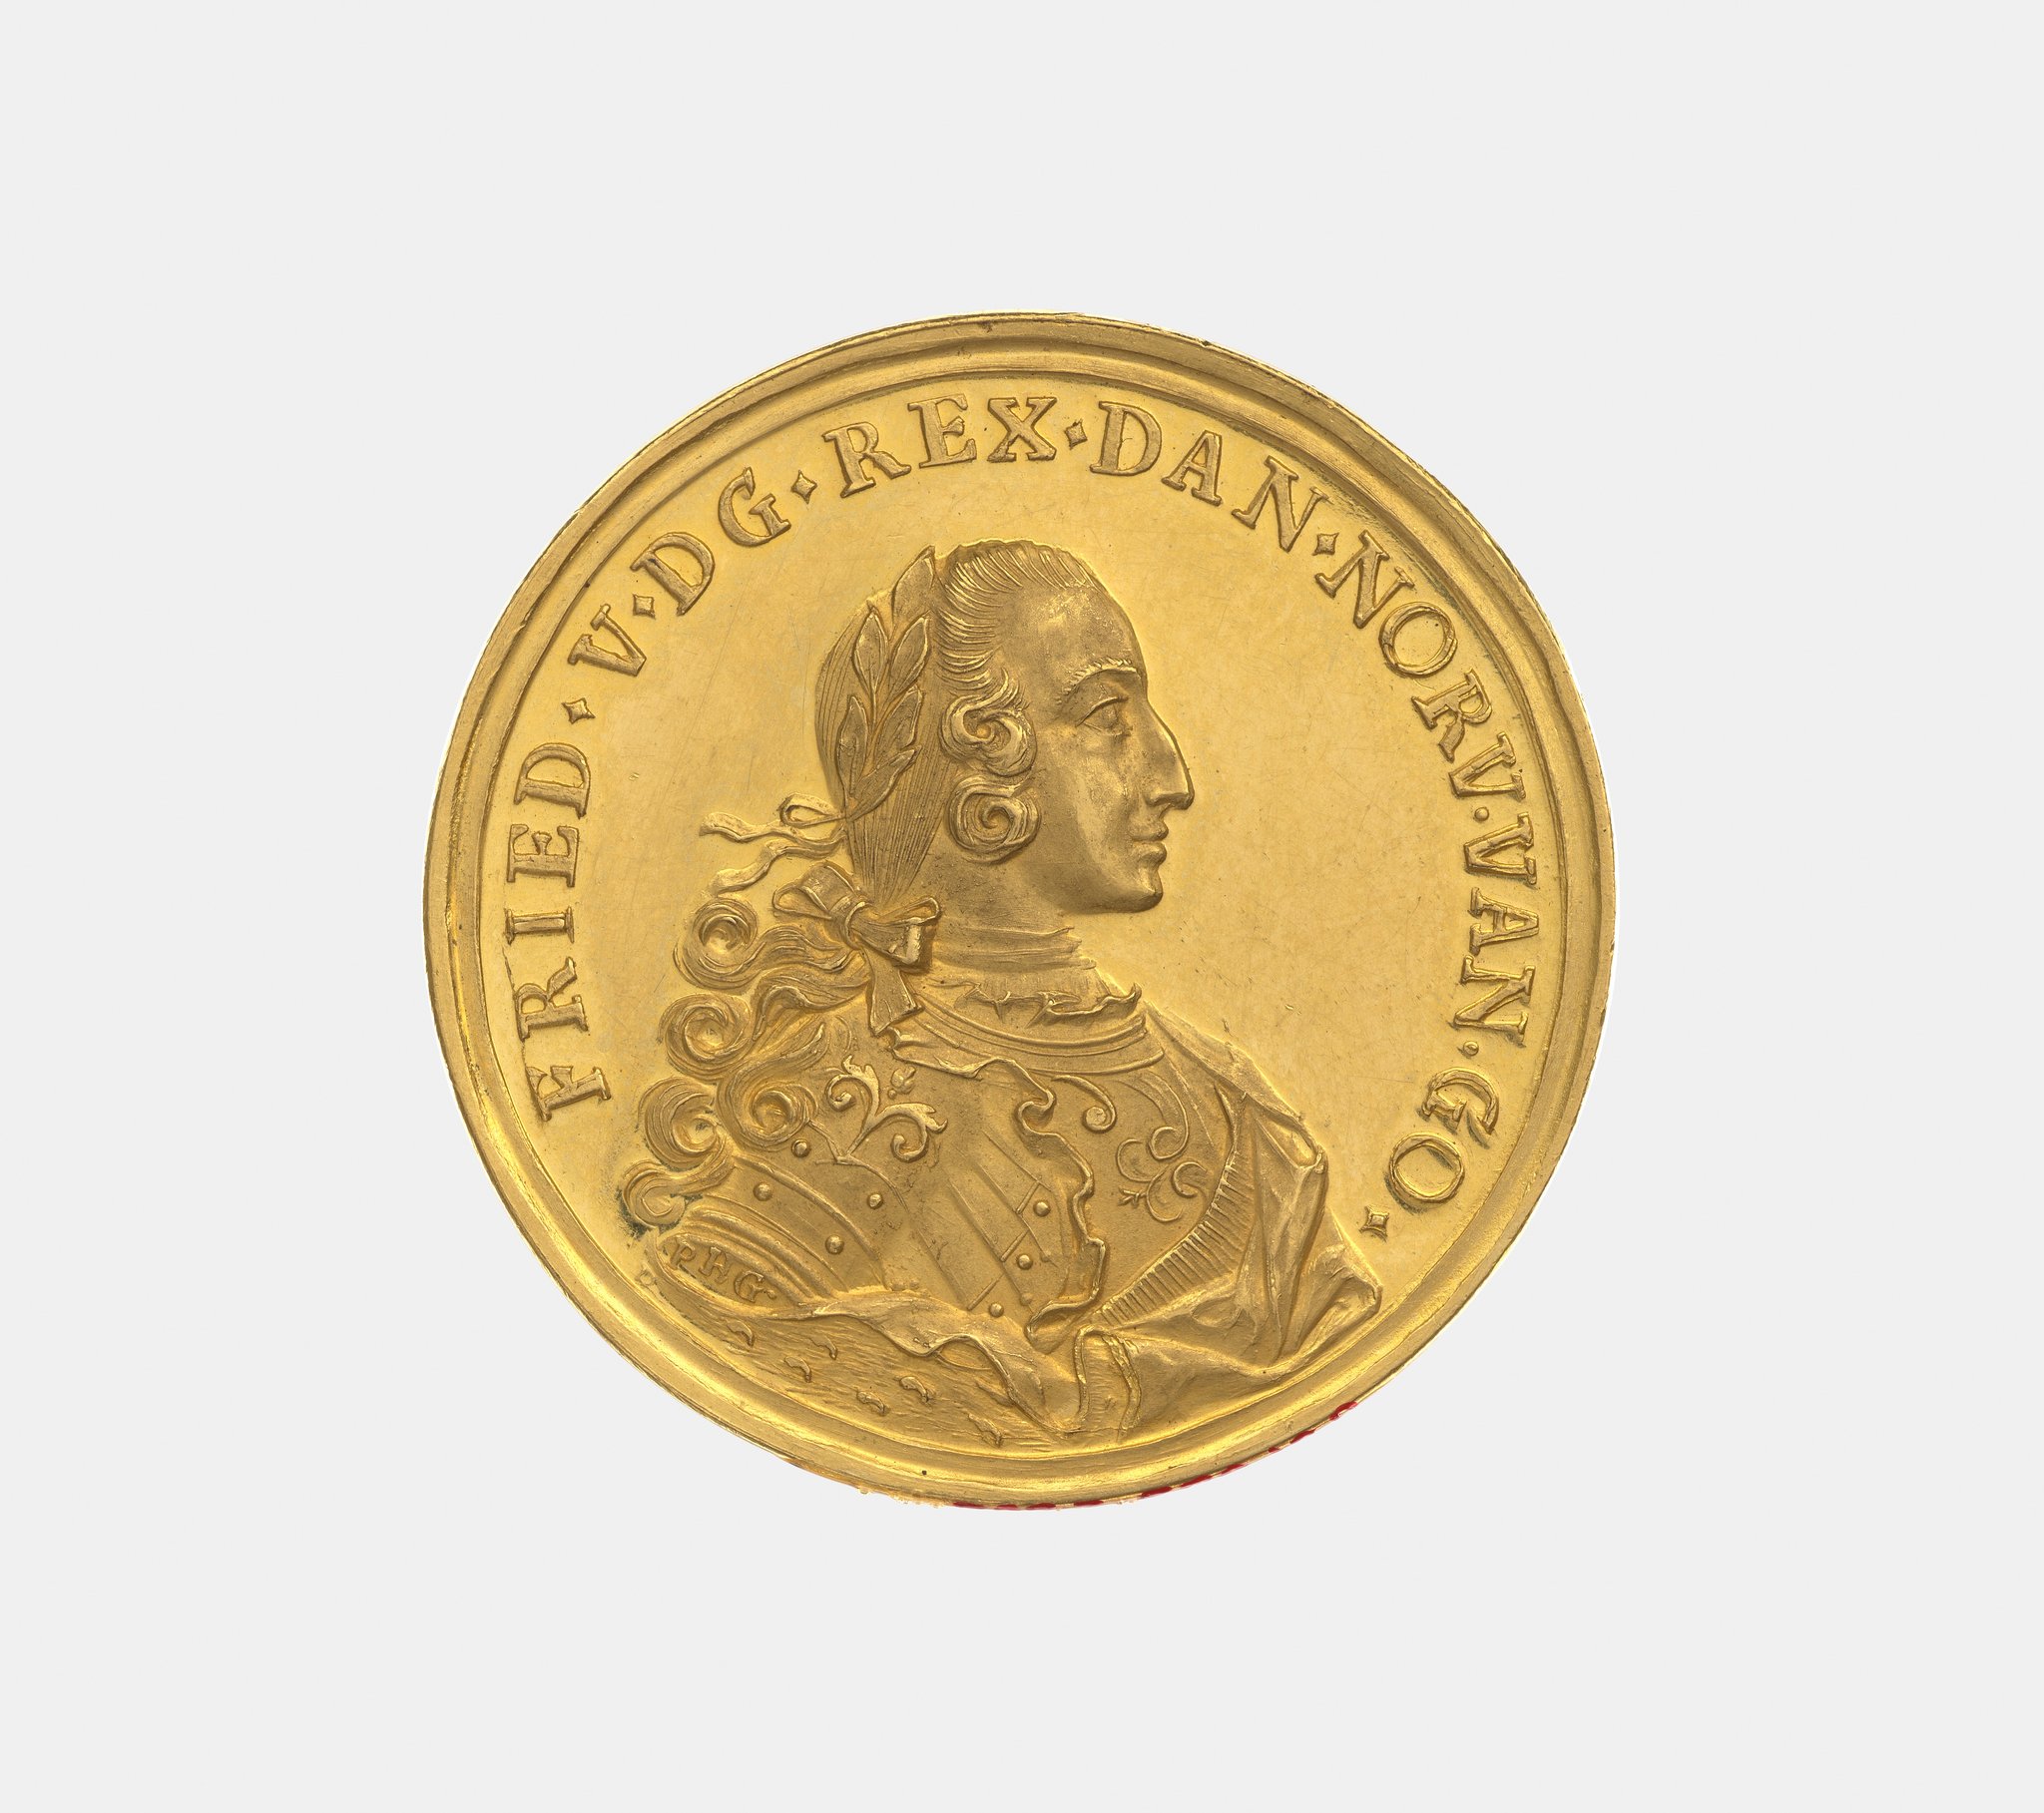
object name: medal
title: Frederick V 1723-66, King of Denmark and Norway 1746-66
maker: paul heinrich goedecke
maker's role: artist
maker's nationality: german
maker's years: 1730-1764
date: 1749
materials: gold